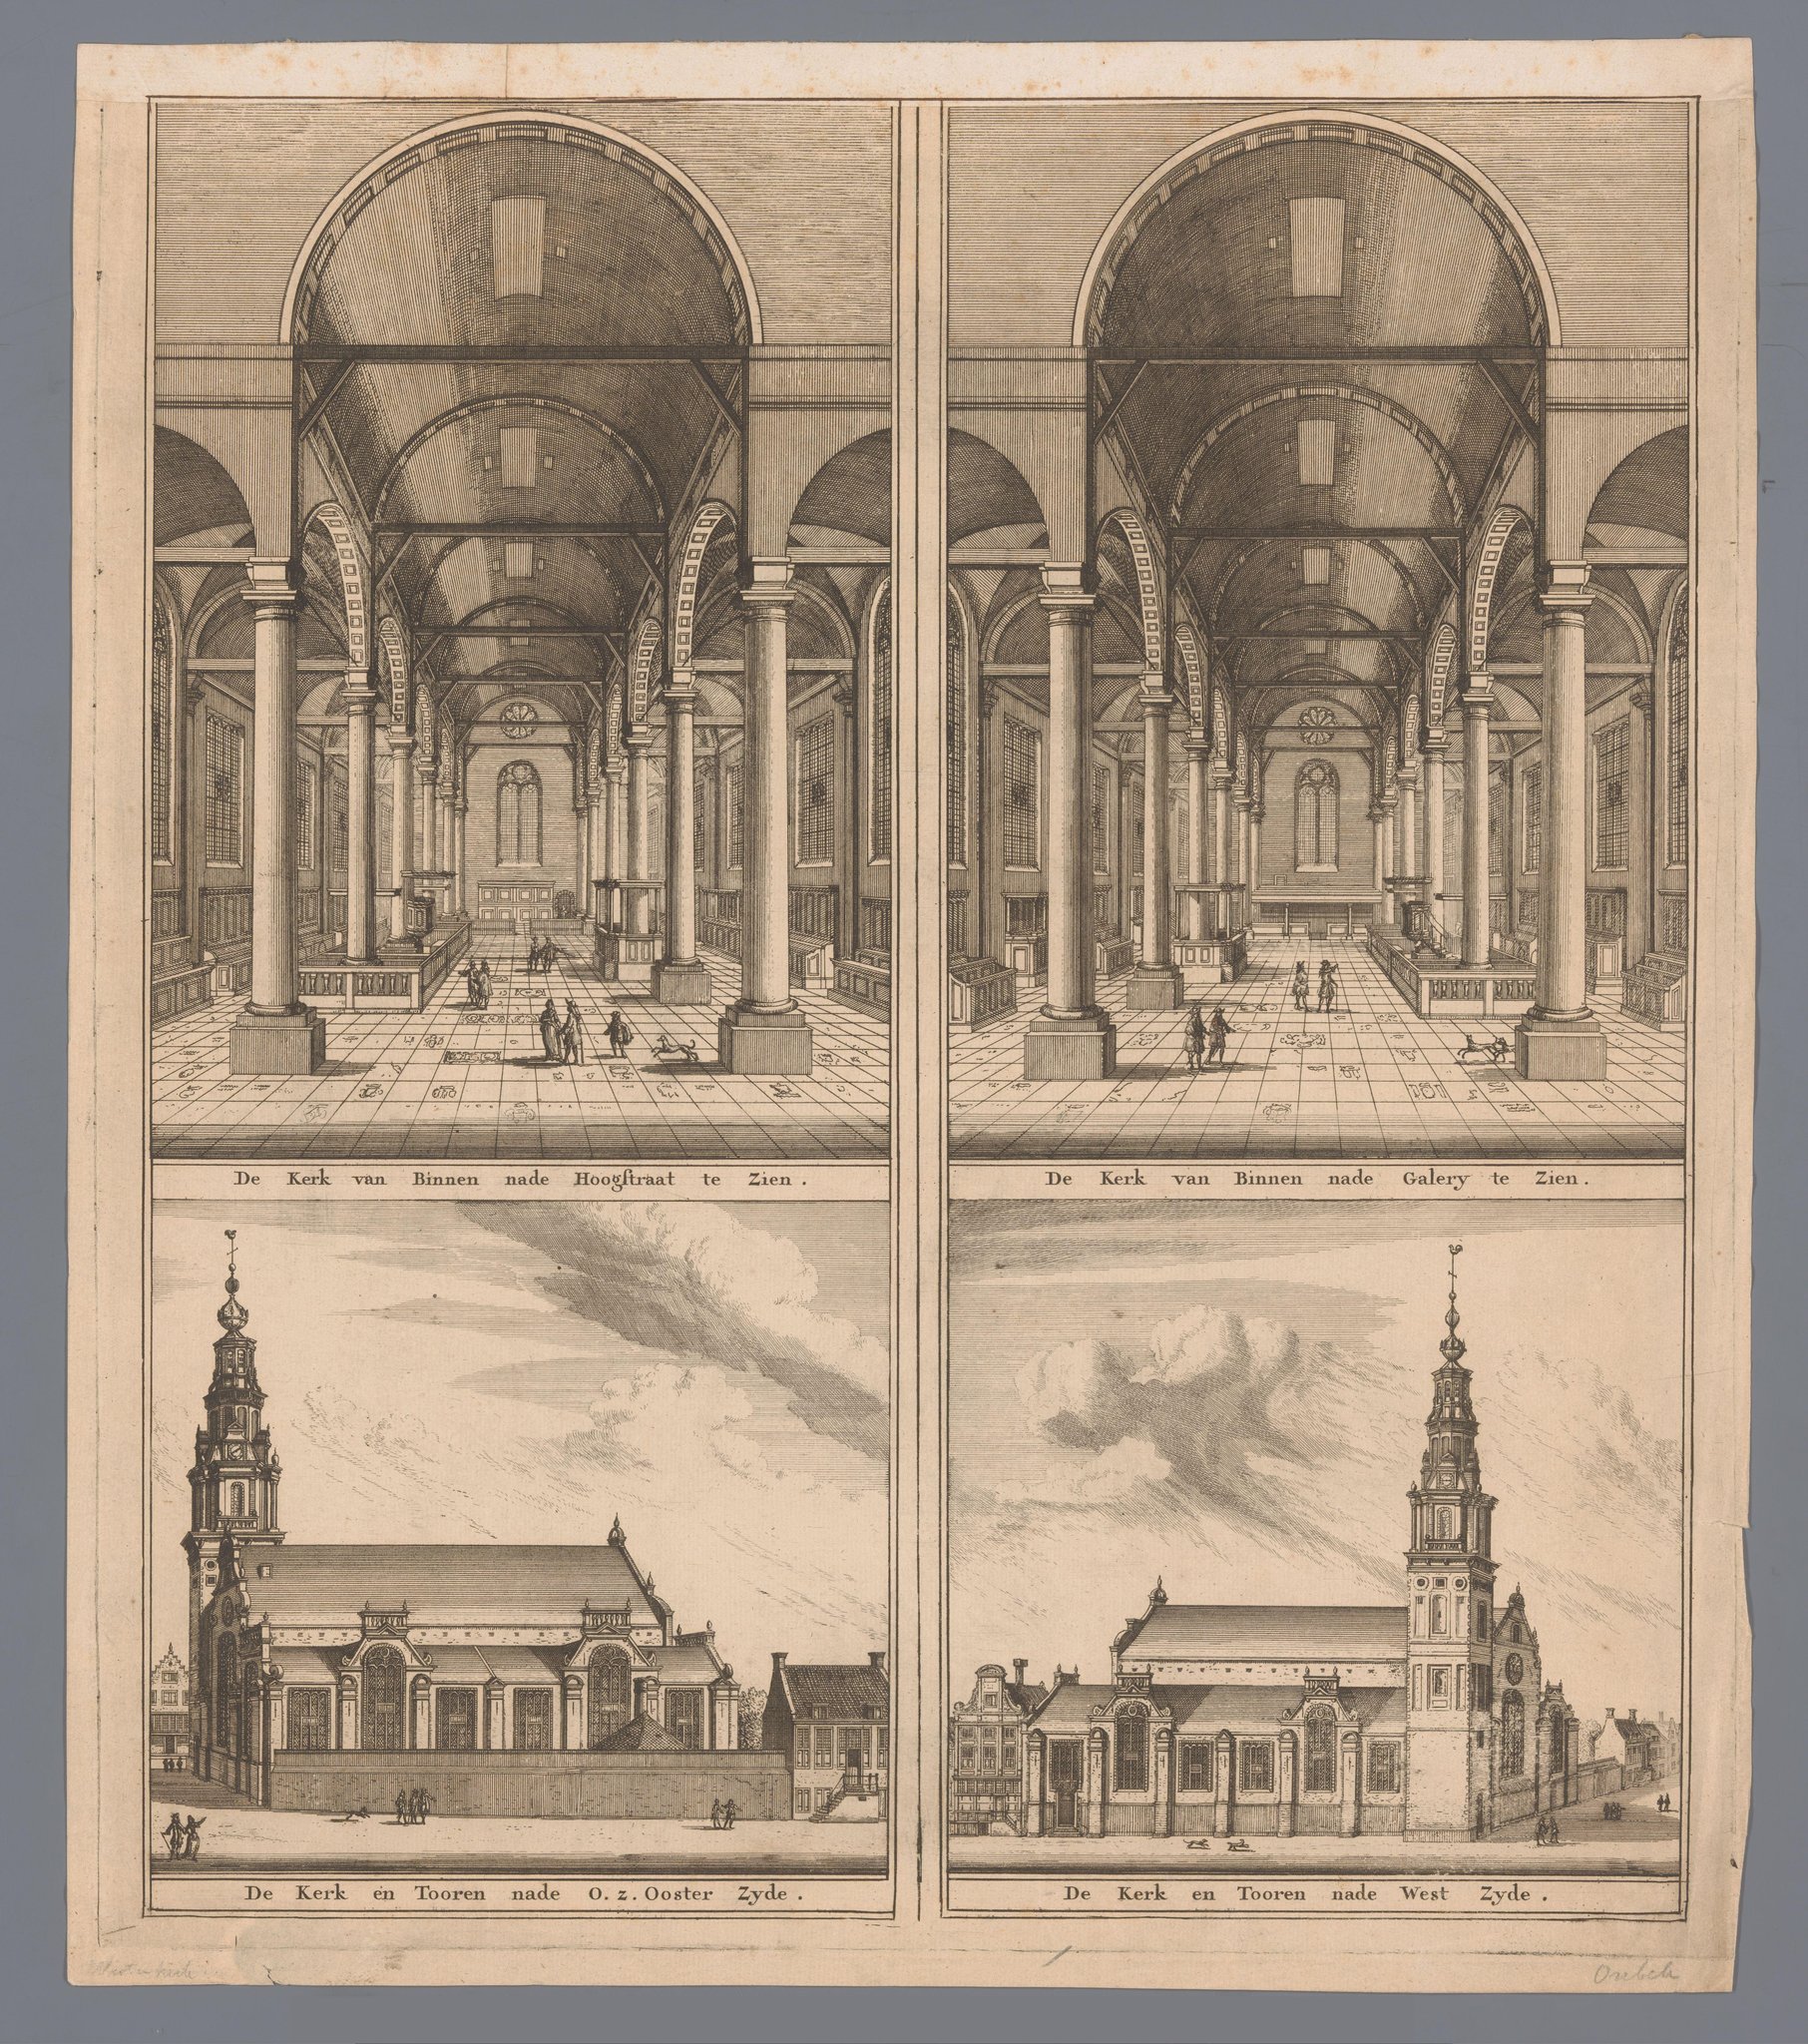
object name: print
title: De Kerk van Binnen nade Galery te zien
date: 1685-1737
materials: paper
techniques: engraving, etching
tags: church (exterior), interior of church, street (+ city(-scape) with figures, staffage)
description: Is mogelijk oorspronkelijk één van de randprenten van 'Afbeelding vande Sit plaatsen inde Zuyder Kerk', een plattegrond van de zitplaatsen in de Zuiderkerk. Pieter van den Berge staat als prentmaker vermeld op de plattegrond zelf, de randprenten zijn mogelijk ook door hem gemaakt. Een andere optie is dat het oorspronkelijk één van de randprenten van een soortgelijke plattegrond (geen exemplaar bekend) gemaakt door Daniël Stopendaal is. In dat geval zouden de randprenten mogelijk door hem zijn gemaakt. Zie RP-P-AO-23-40B, RP-P-AO-23-41A en RP-P-AO-23-41B voor andere bijhorende randprenten. Zie RP-P-AO-23-57 voor een soortgelijke plattegrond van de Oosterkerk met randprenten.